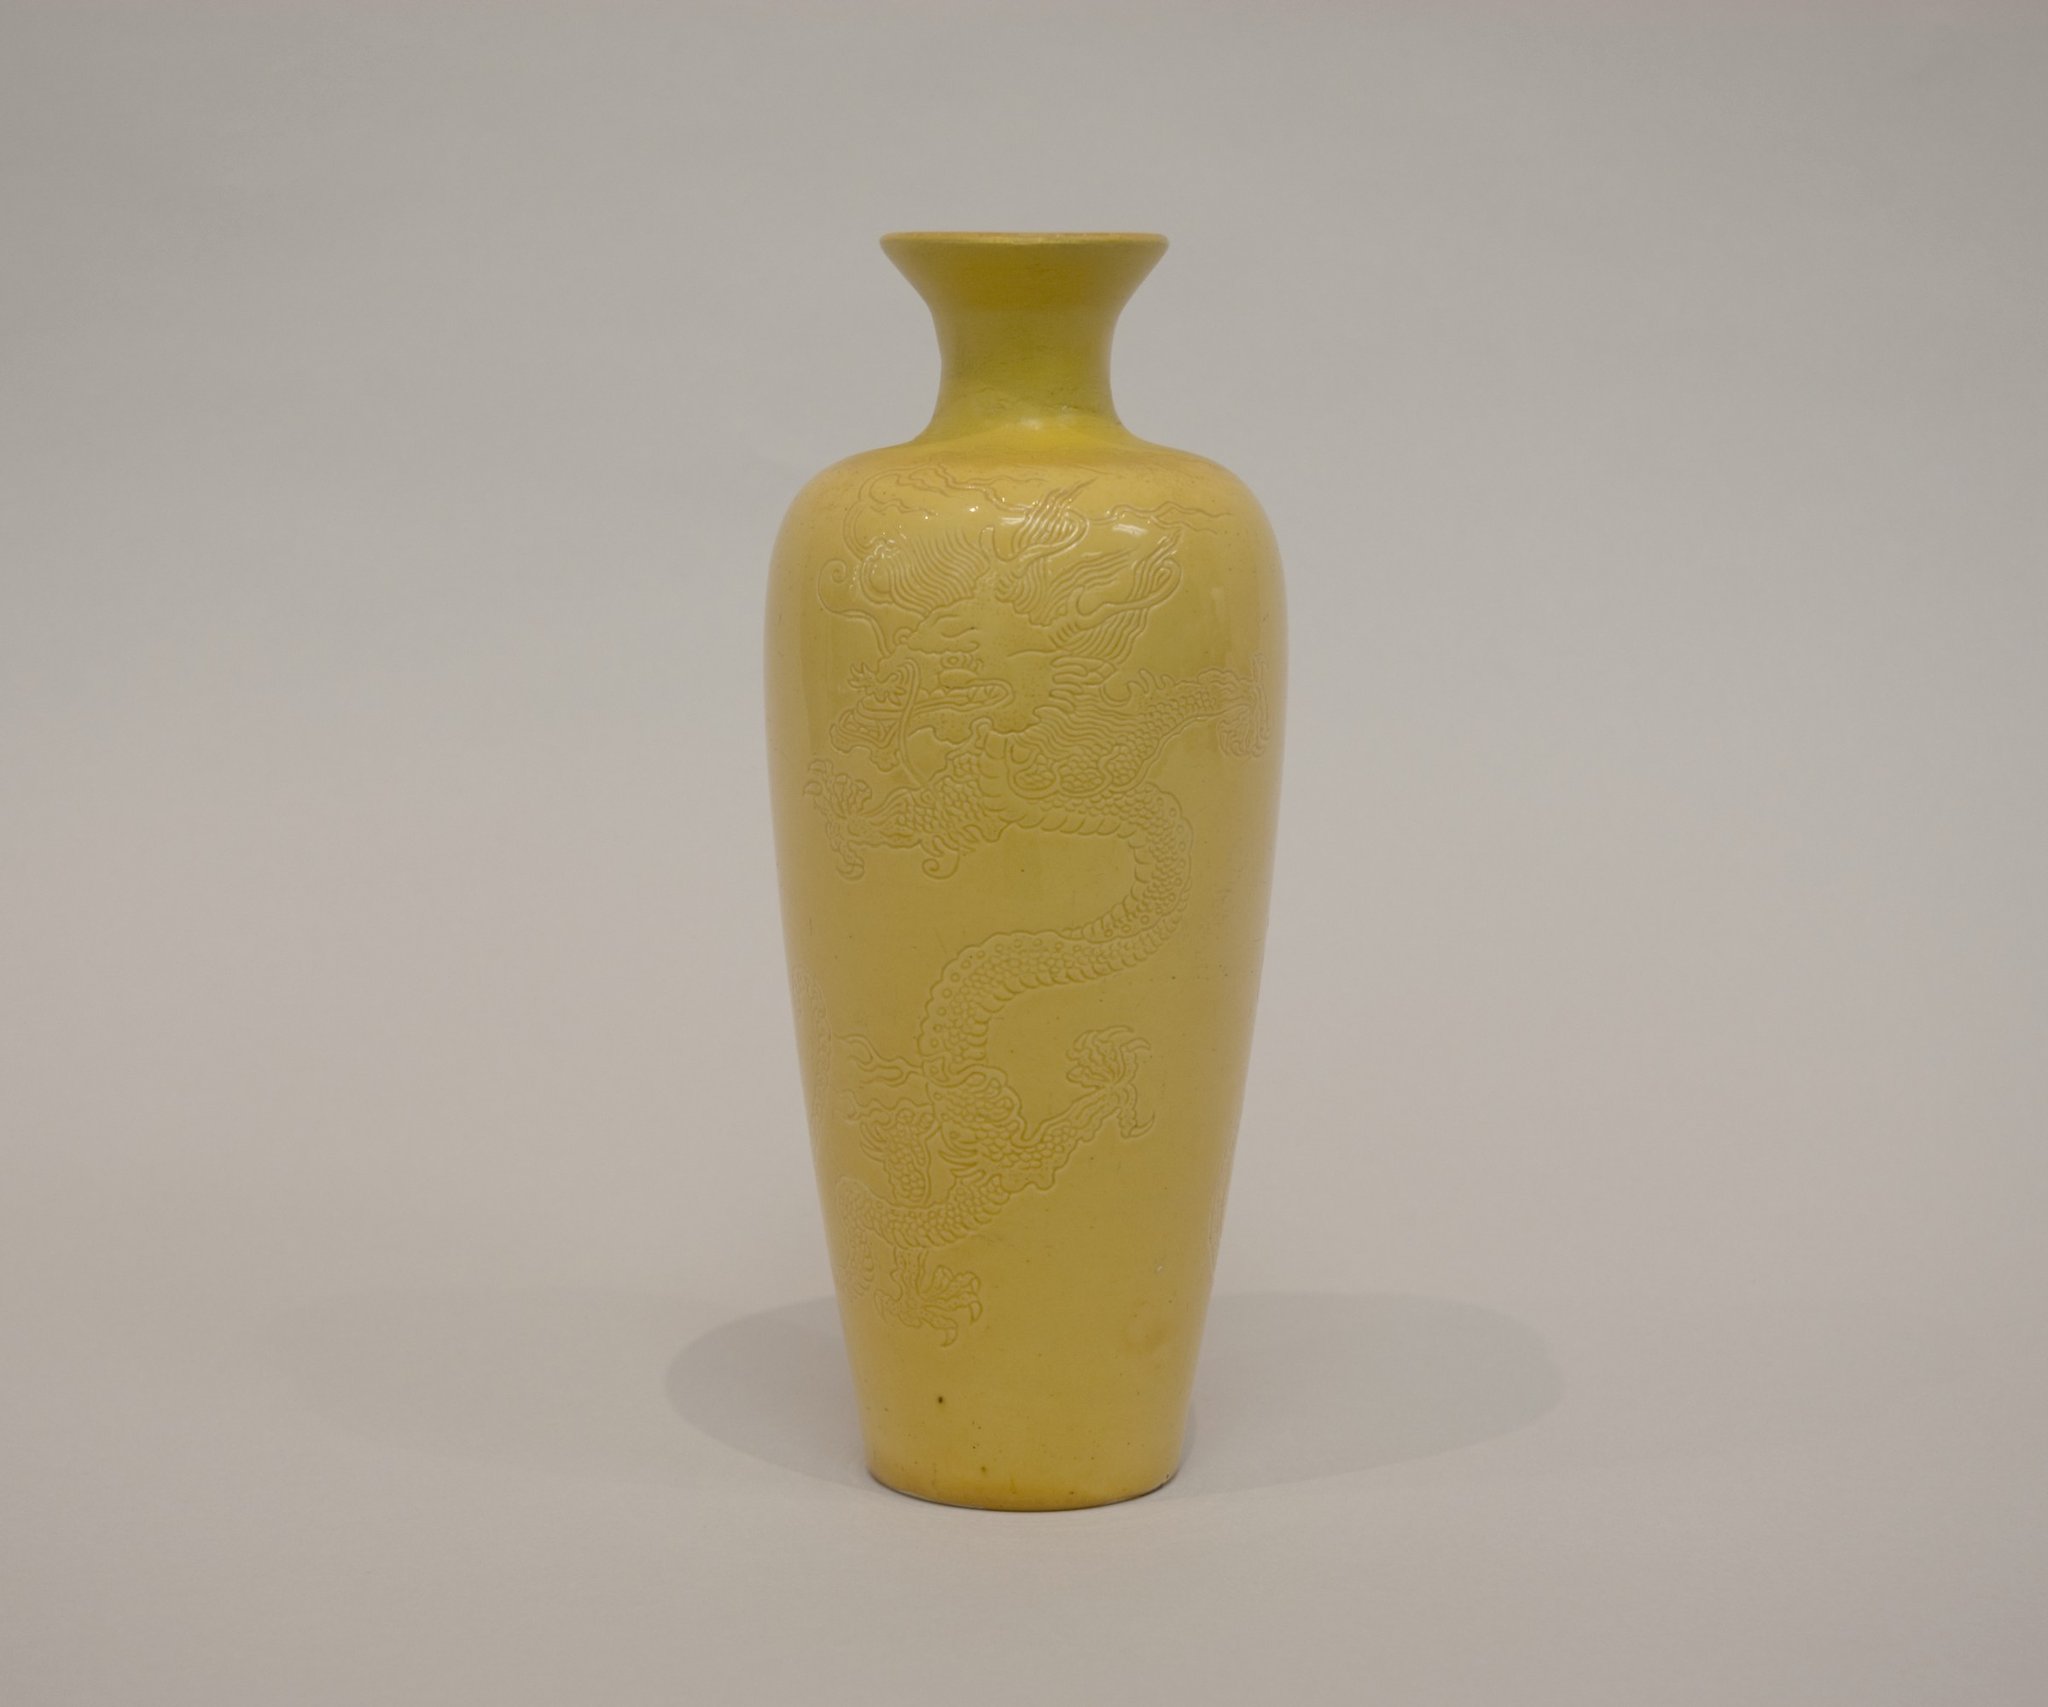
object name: vase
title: Vase with dragon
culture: chinese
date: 1667-1733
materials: glaze, porcelain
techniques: incising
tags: dragons